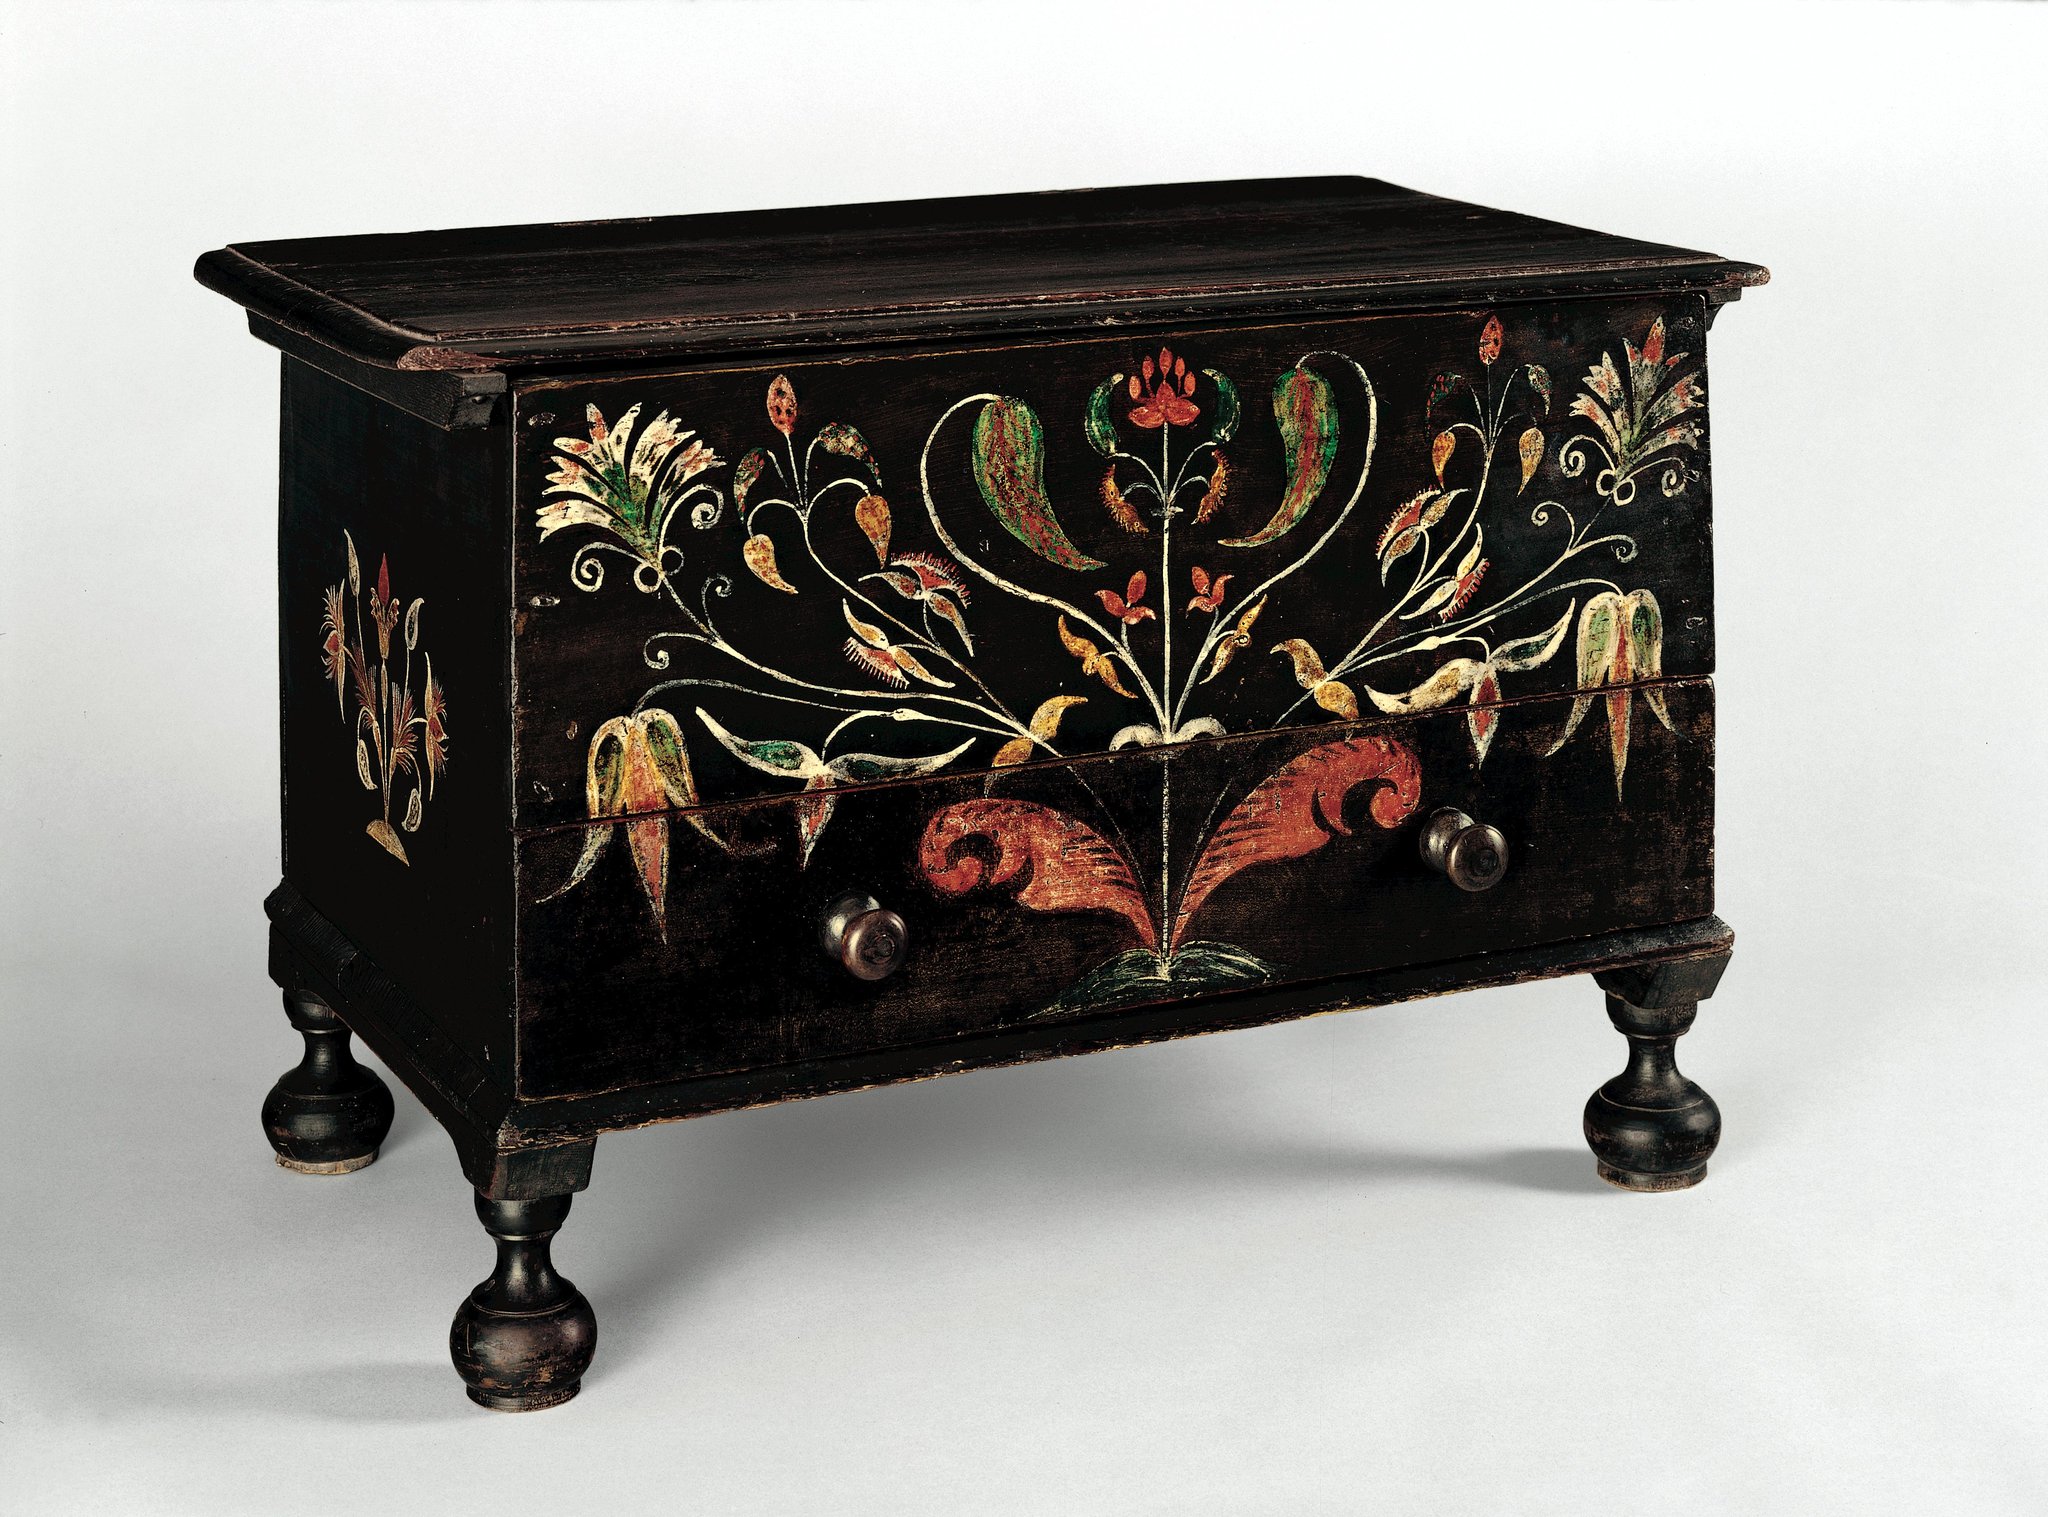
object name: chest of drawer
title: Chest with drawer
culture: american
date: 1705-1725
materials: wood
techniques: painting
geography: united states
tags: flowers